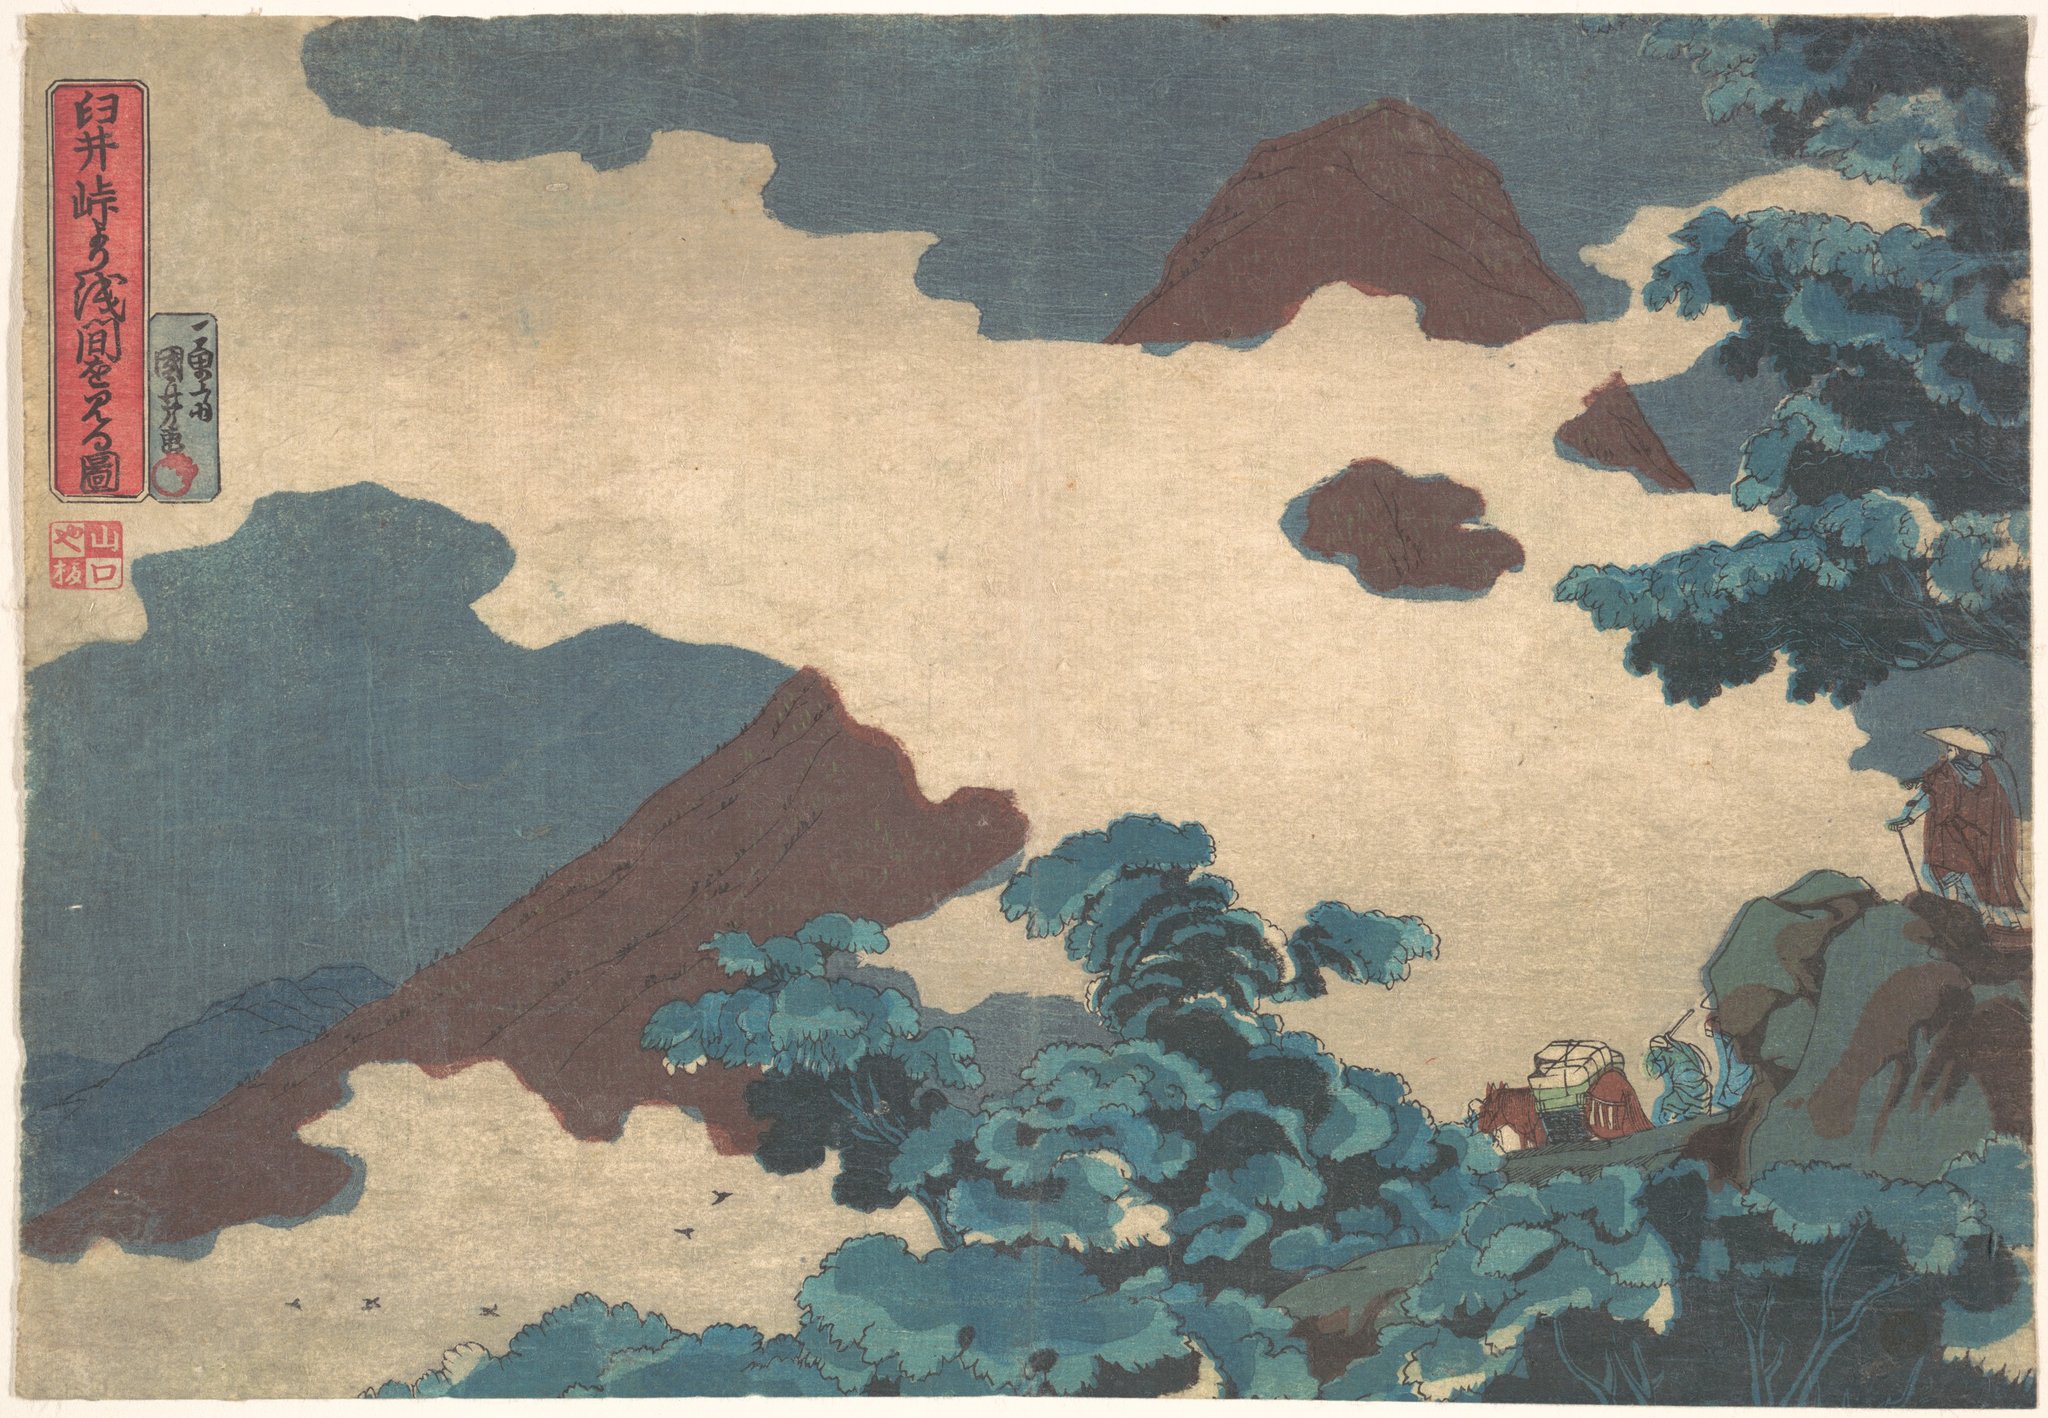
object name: print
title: View of Mt. Asama from the Usui Pass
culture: japanese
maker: utagawa kuniyoshi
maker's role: artist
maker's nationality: japanese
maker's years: 1797-1861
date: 1850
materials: ink, paper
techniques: woodblock print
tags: mountains,trees